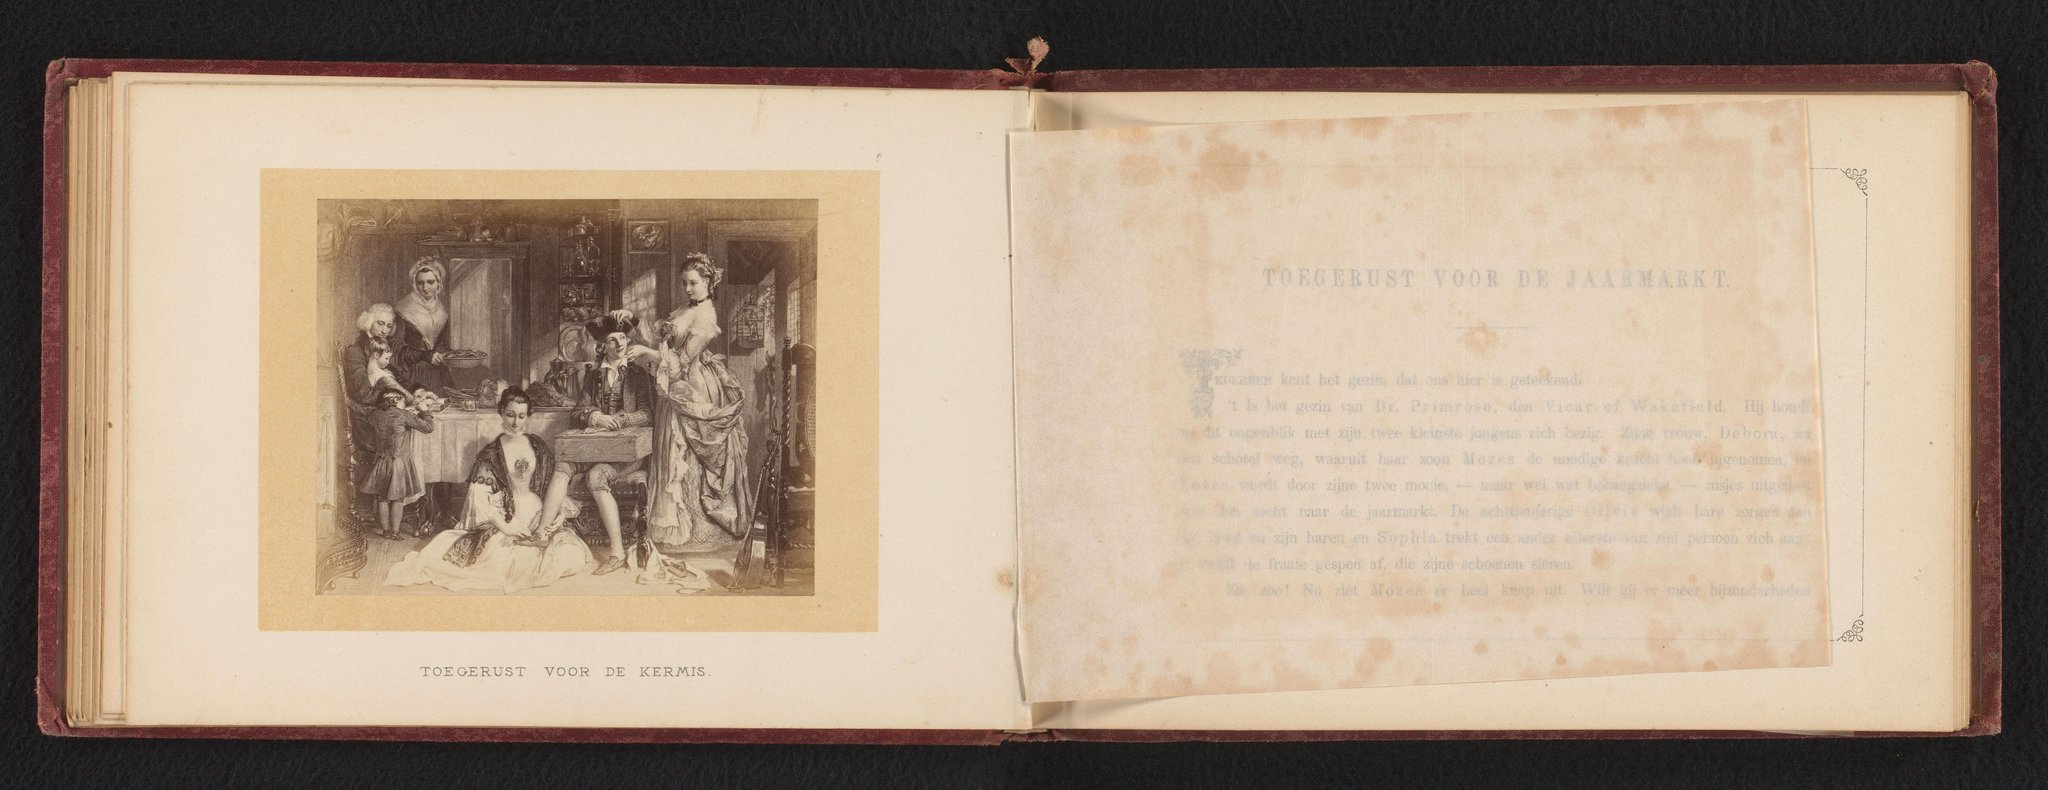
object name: reproduction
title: Toegerust voor de kermis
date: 1872-1875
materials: paper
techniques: albumen print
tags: print, e.g.: engraving, etching, lithograph, family life at home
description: Foto op ongenummerde pagina. Het betreft hier een scène uit de roman The Vicar of Wakefield.